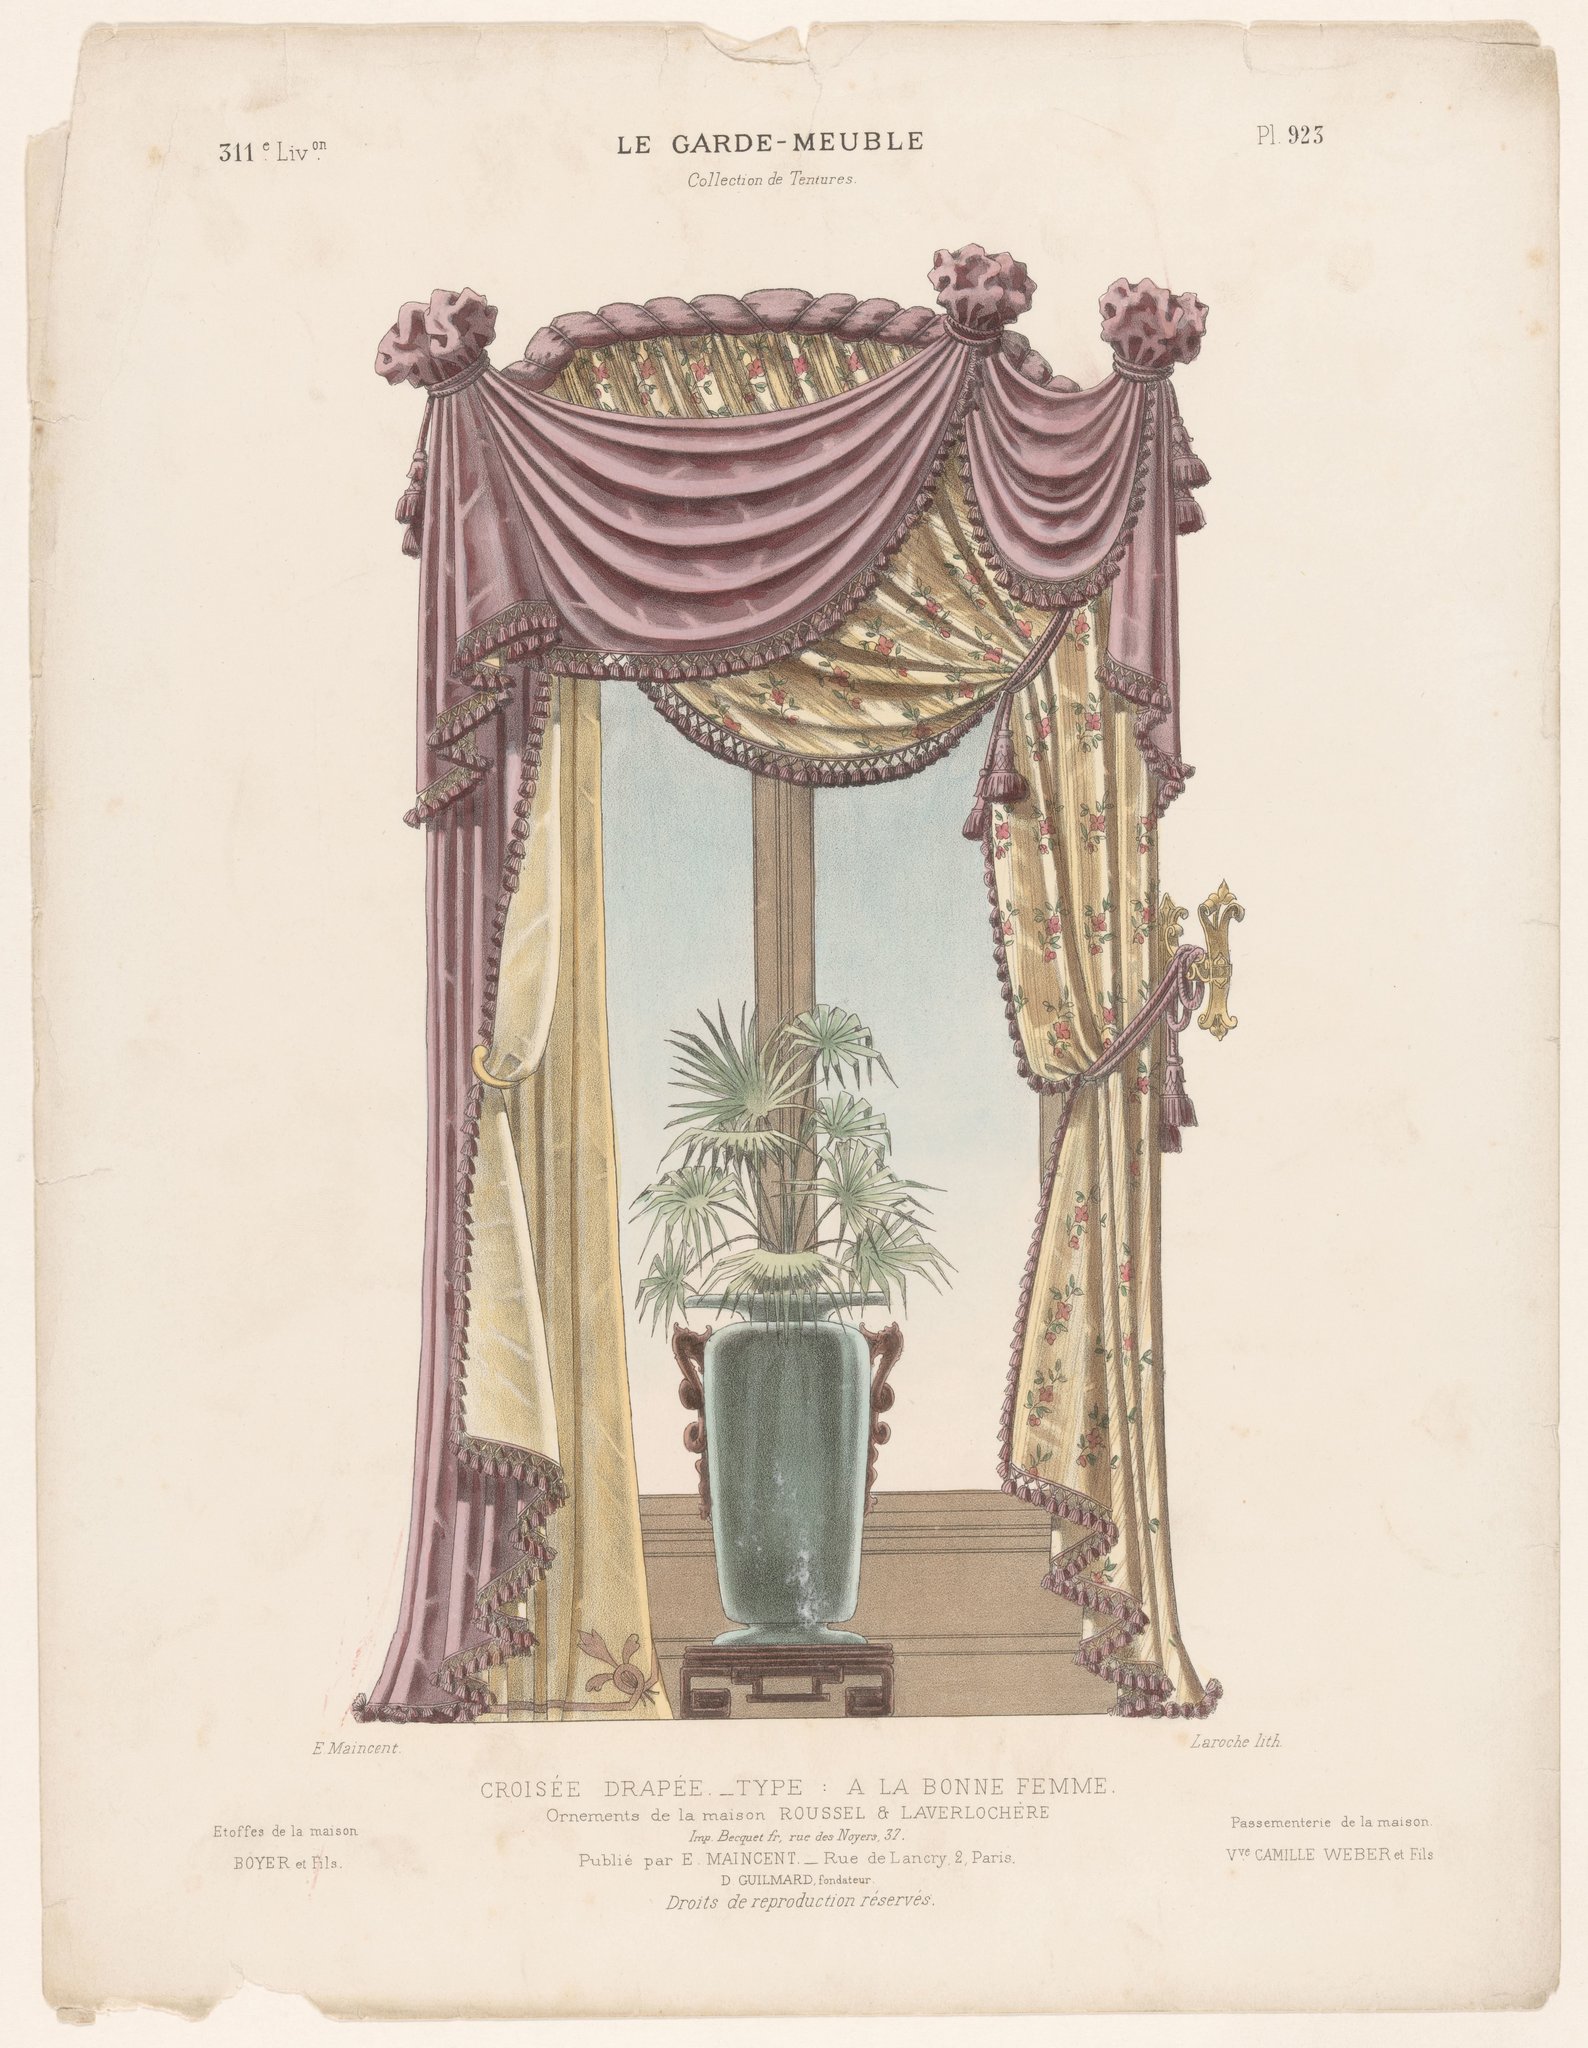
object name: print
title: Venster met gordijn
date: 1885-1895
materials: paper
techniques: hand coloring, lithograph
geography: paris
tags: window, hangings and drapery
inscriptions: : ‘Droits de reproduction réservés.’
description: Kruisvenster met vaas en gedrapeerde gordijnen. Prent uit 311e Livraison.